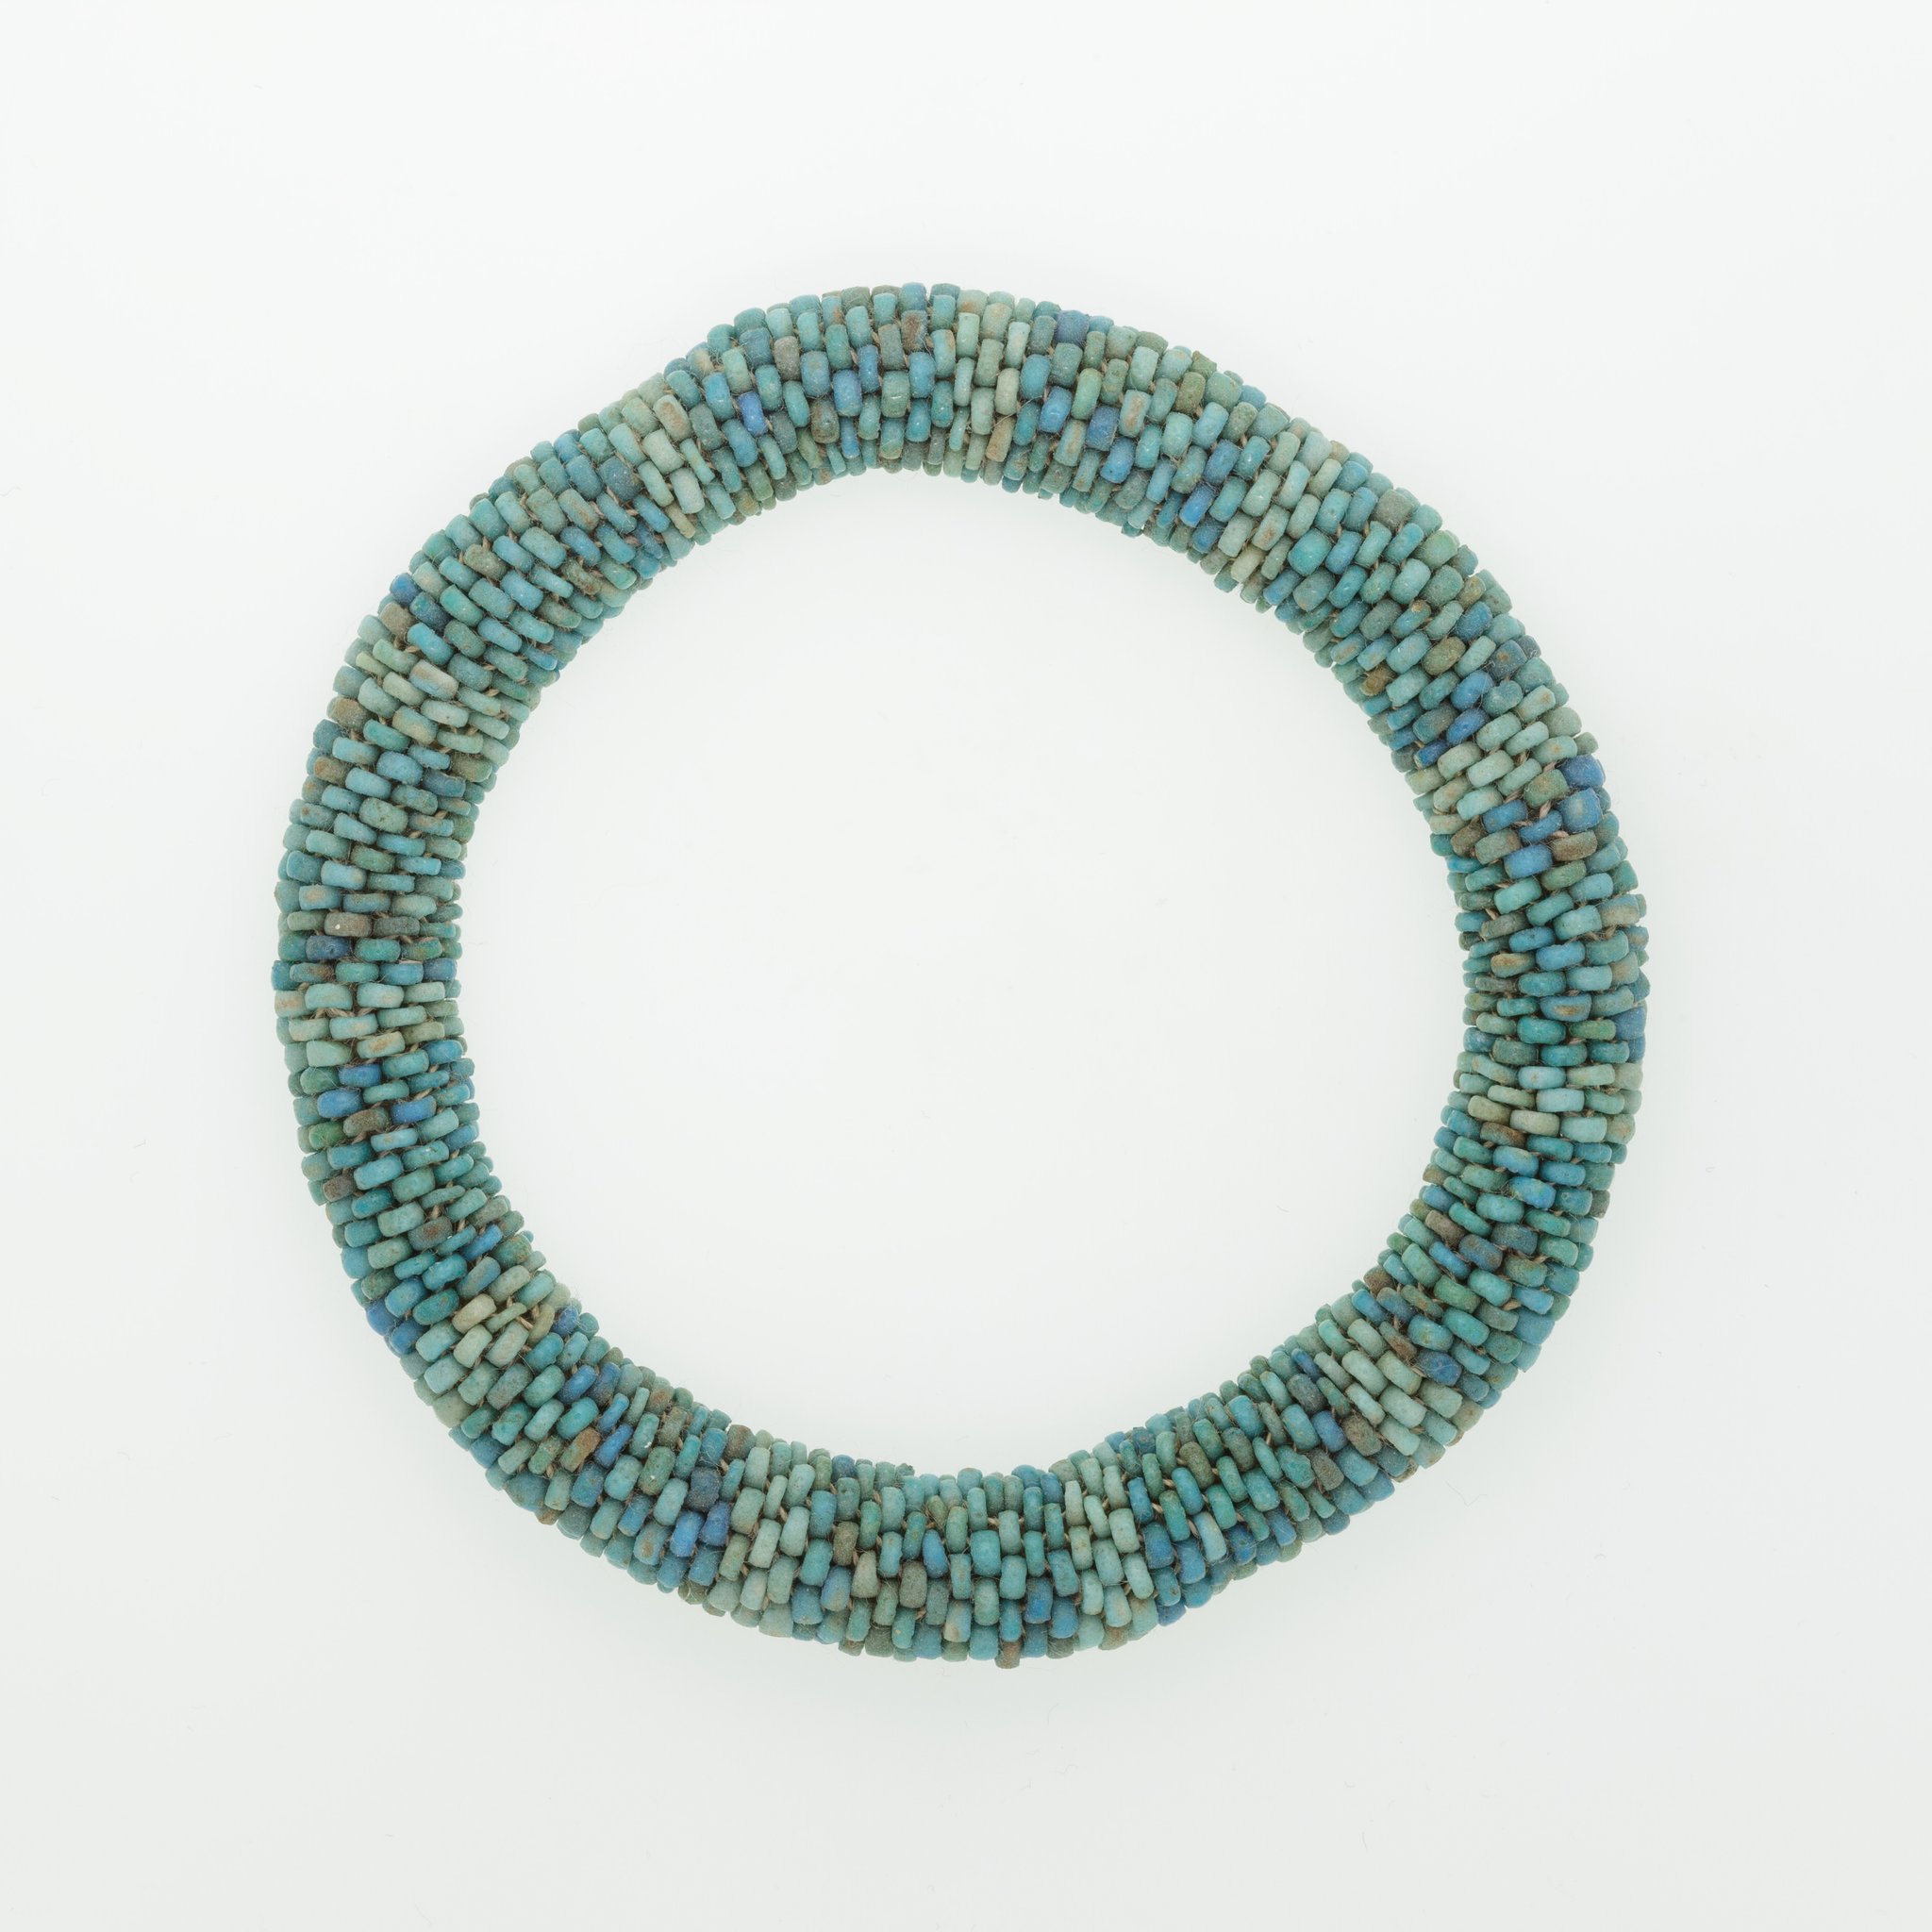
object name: bracelet or armlet, baki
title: Beaded Bracelet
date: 1504-1447 BCE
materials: faience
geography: egypt